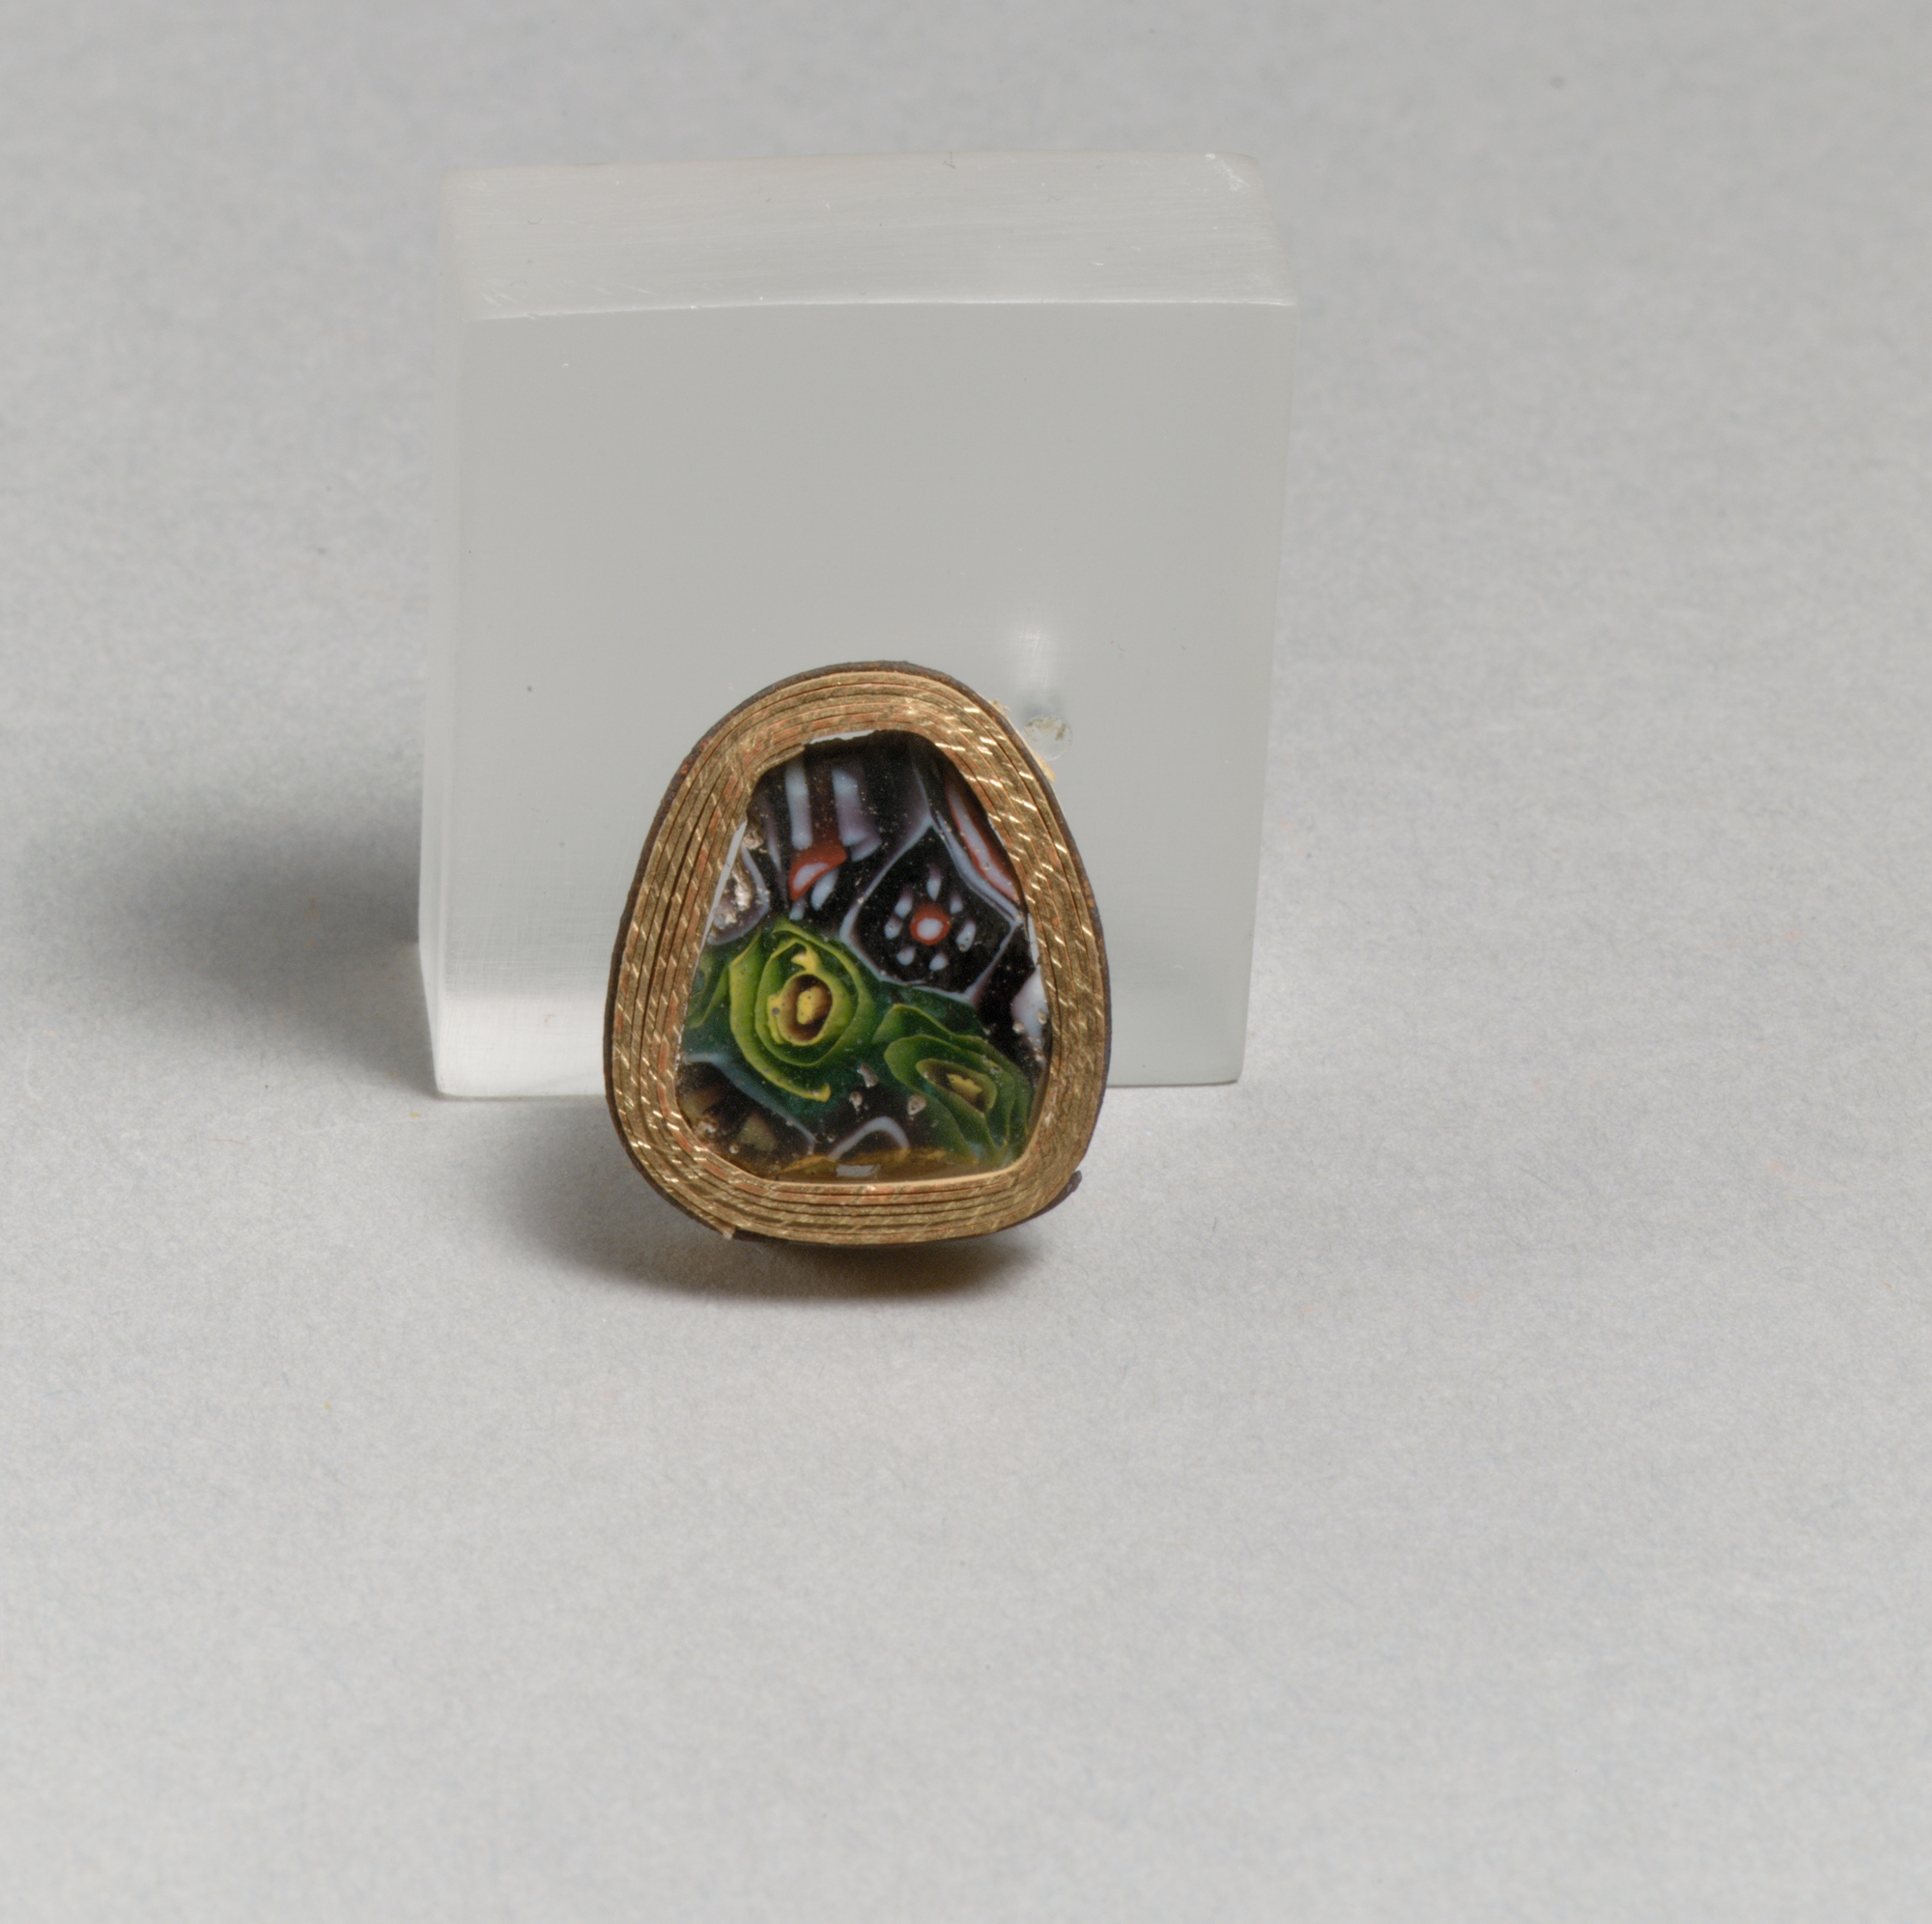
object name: fragment, mosaic bowl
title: Glass mosaic carinated bowl fragment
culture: roman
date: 34 BCE-33 CE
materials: glass